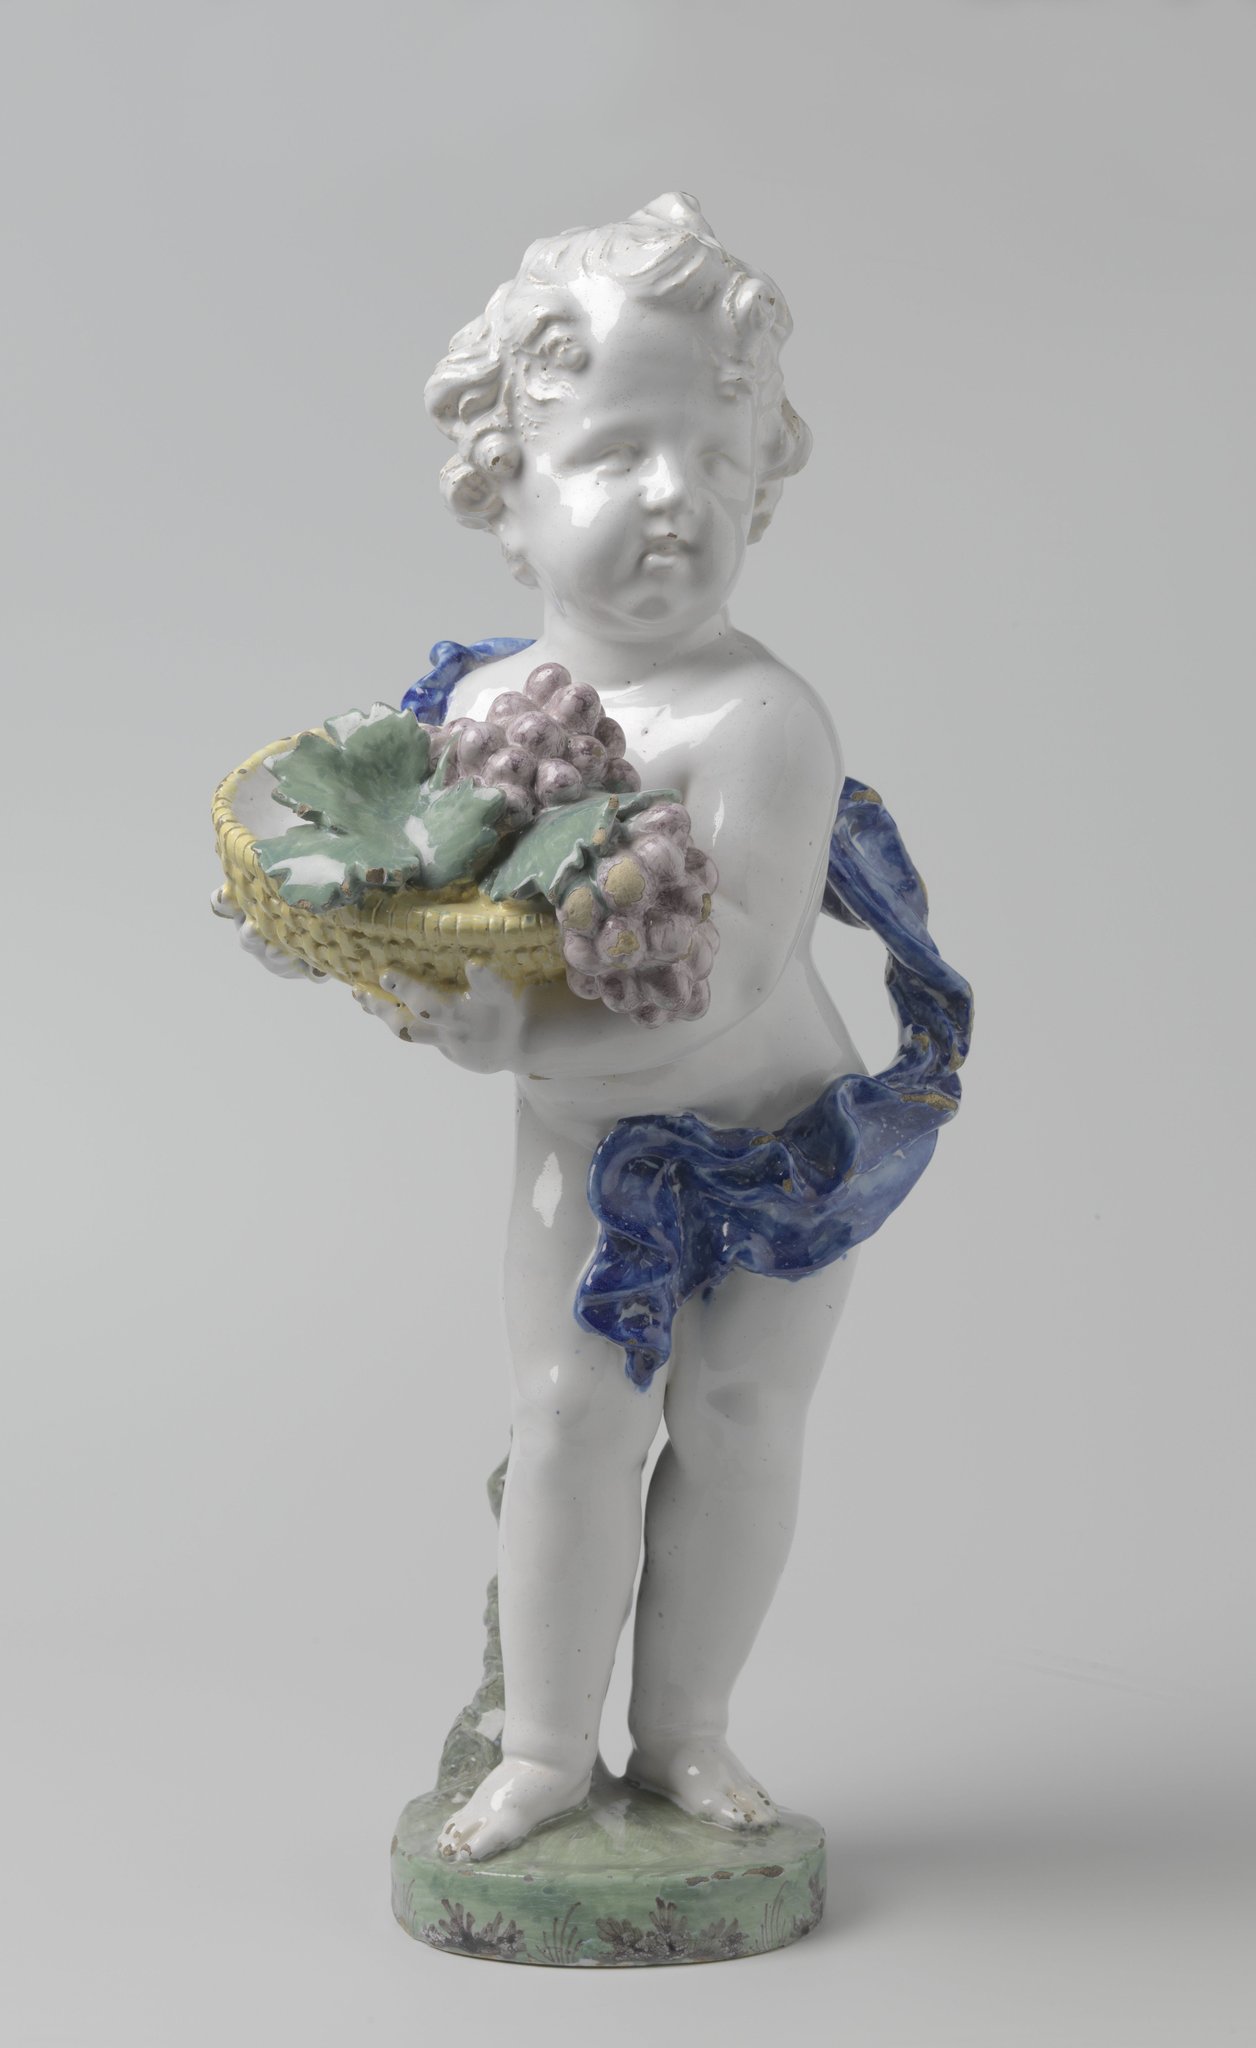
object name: decoratief object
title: Putto van ongedecoreerde faïence met in linkerarm een mand met druiven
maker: Anonymous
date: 1750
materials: earthenware, glaze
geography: brussels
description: Beeld van ongedecoreerde faïence, voorstellende een putto met in zijn linkerarm een mand met druiven. Bij het beeld hoort een tweede beeld.